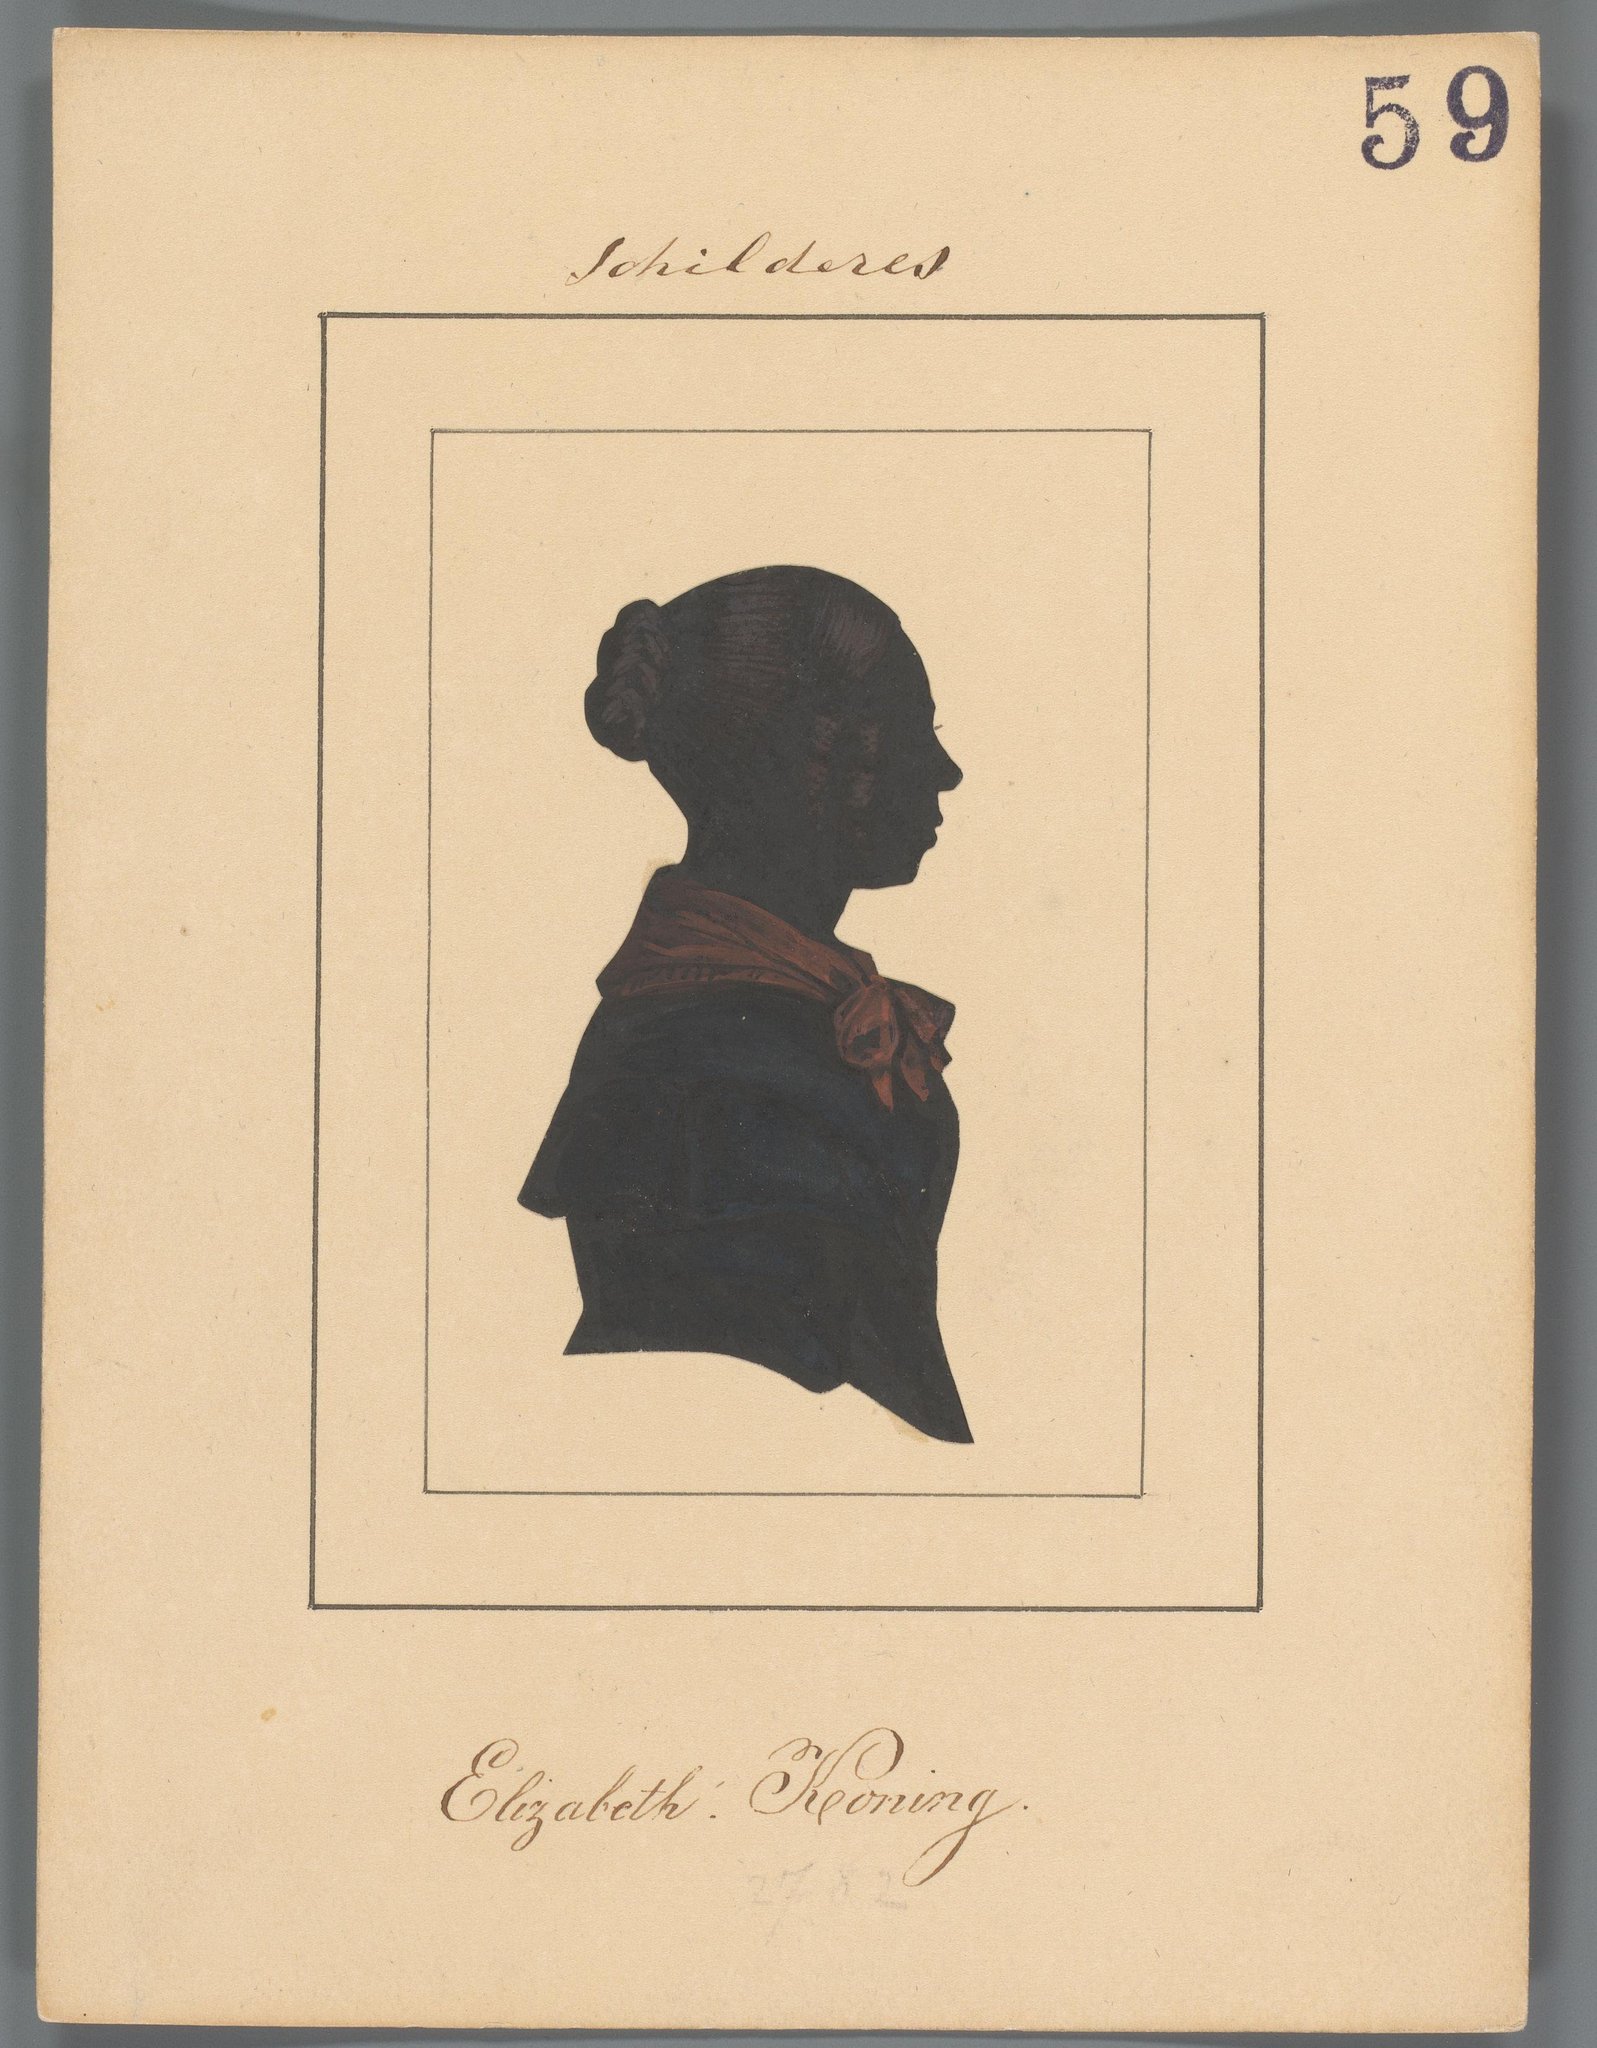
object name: silhouette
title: Silhouetportret van Elisabeth Johanna Koning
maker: elisabeth alida haanen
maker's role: draughtsman, print maker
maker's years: 1809-1845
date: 1819-1845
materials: ink, paint, paper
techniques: brush, snipping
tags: haarlem, rotterdam, elisabeth johanna koning, historical persons - bb - woman, portrait, self-portrait of painter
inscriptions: number: ‘59’, inscription: ‘Schilderes’, inscription: ‘Neg. D. 1734’, number: ‘14007’, inscription: ‘Elizabeth Koning’, collector's mark: ‘Ex-libris van Beresteyn’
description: Met onder het portret de handtekening van de geportretteerde.